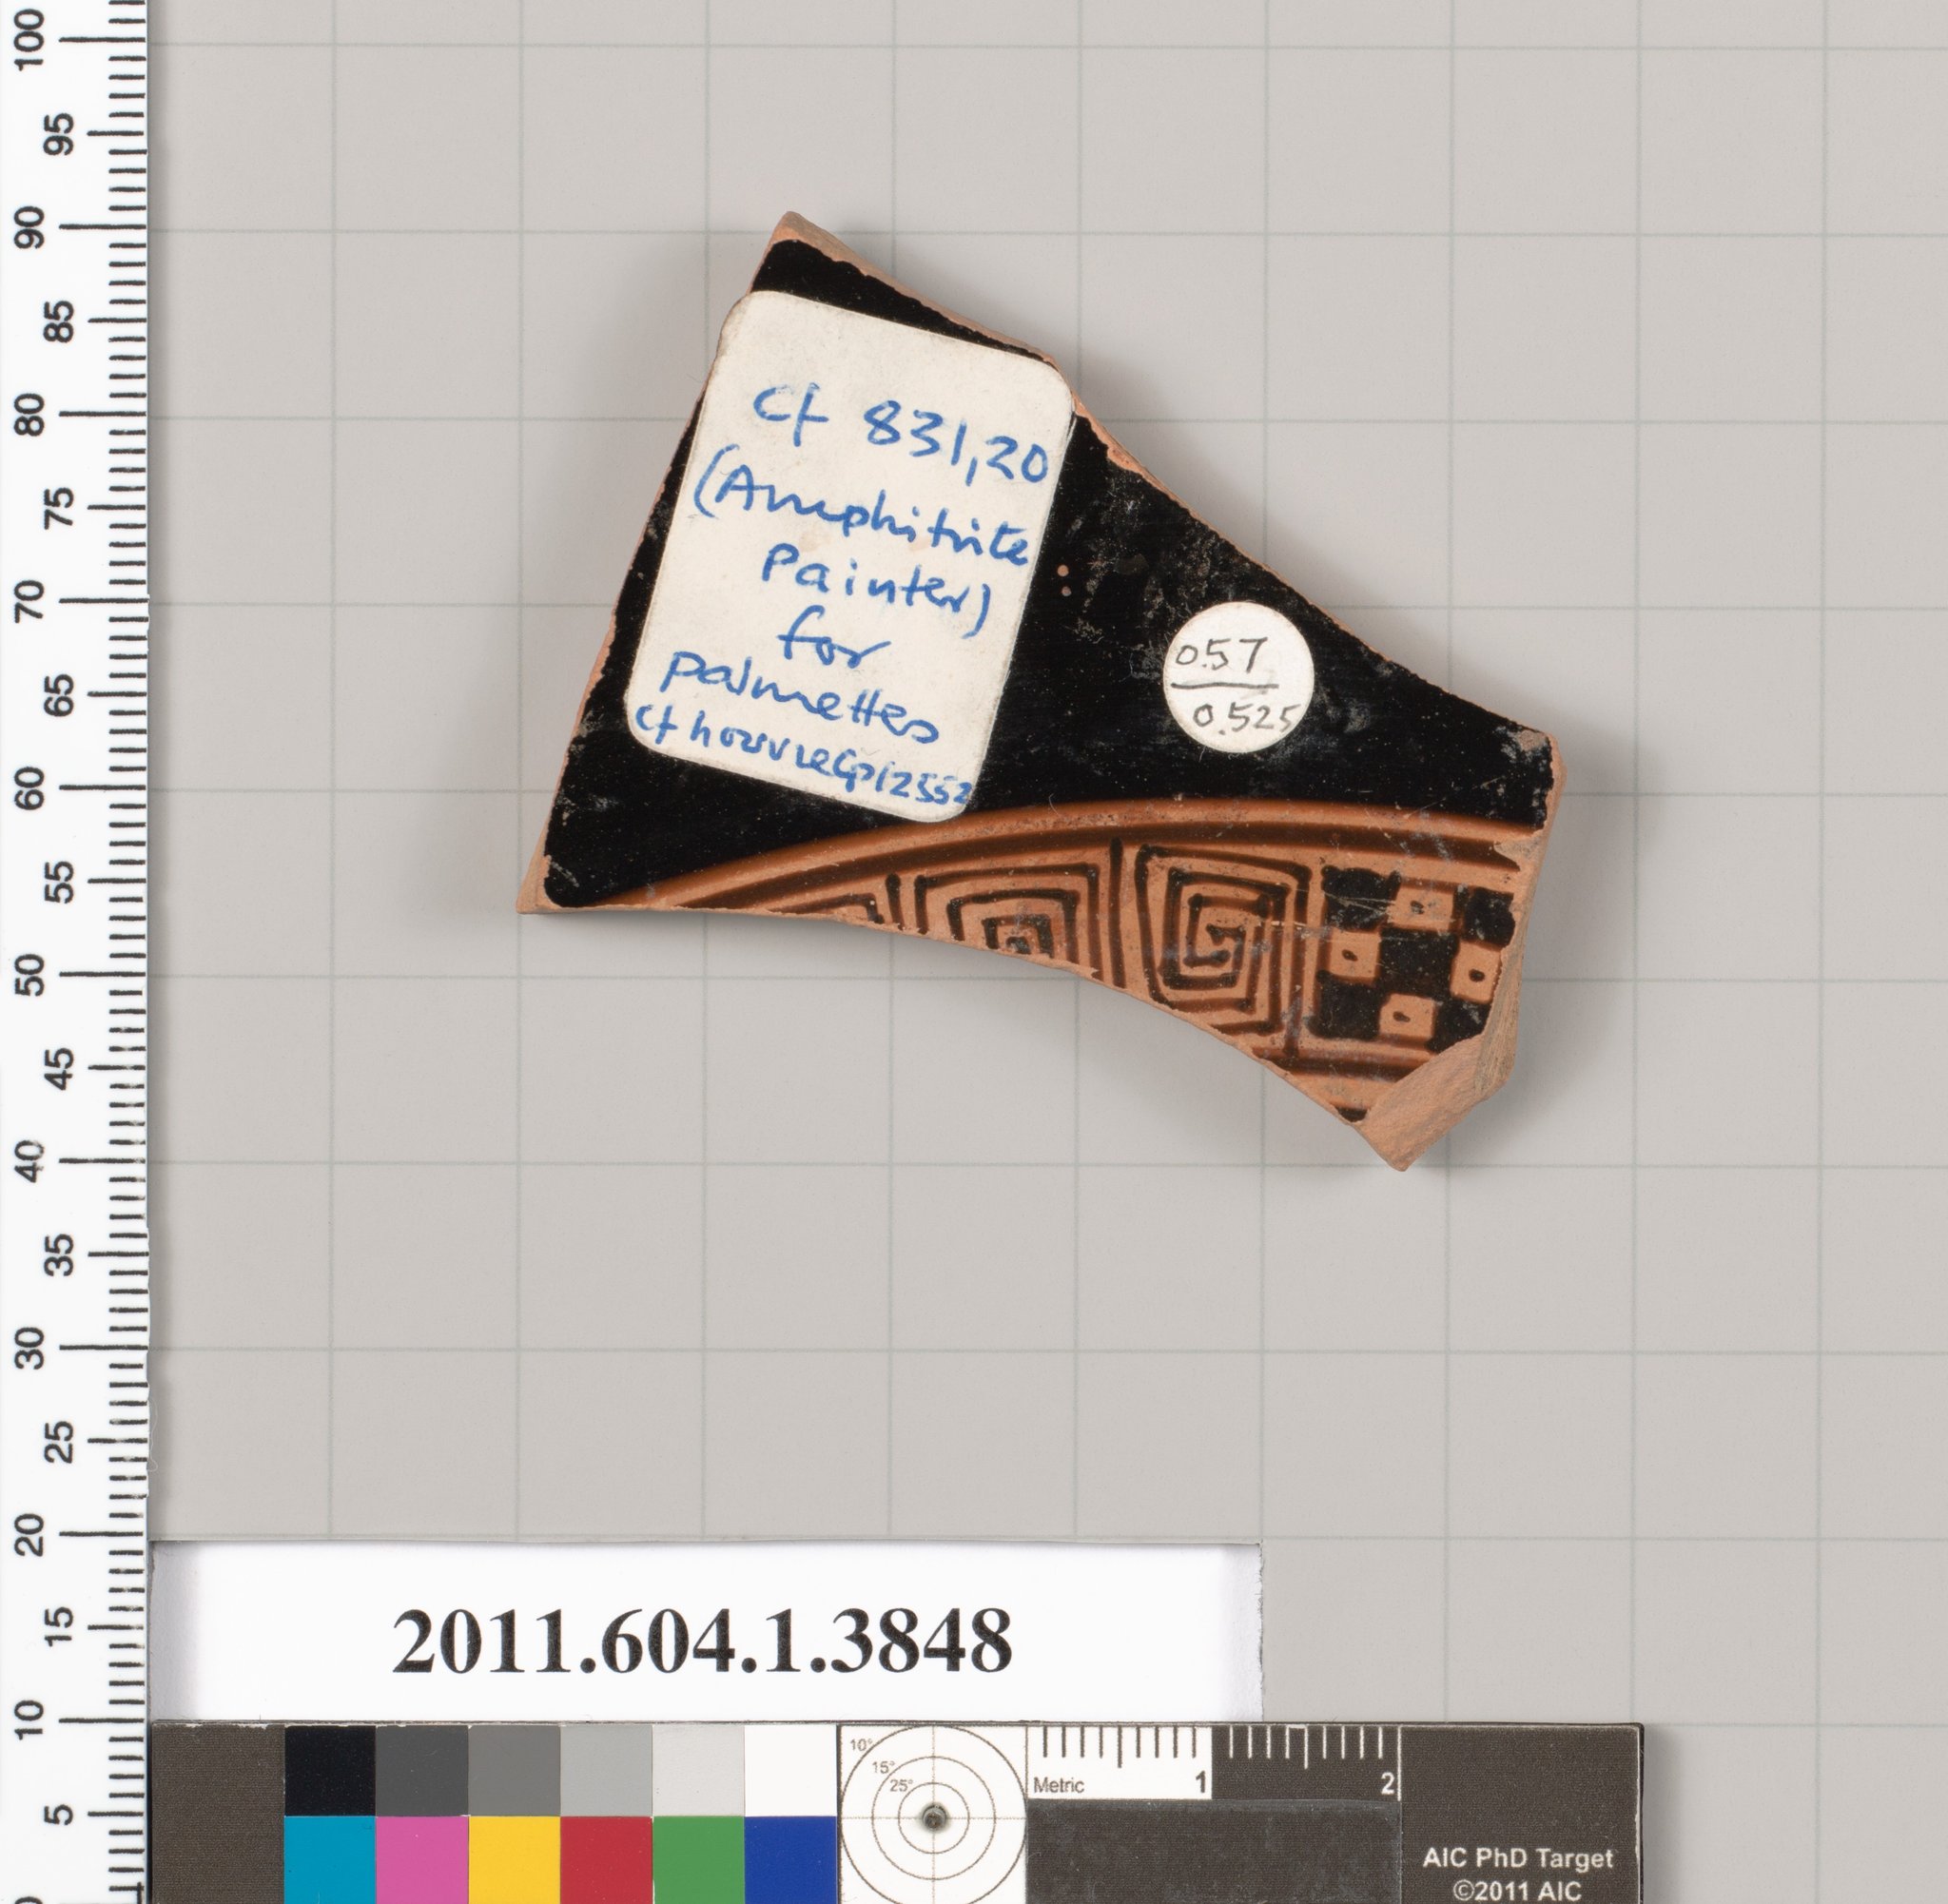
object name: kylix fragment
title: Terracotta fragment of a kylix (drinking cup)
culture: greek, attic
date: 475-451 BCE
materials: terracotta